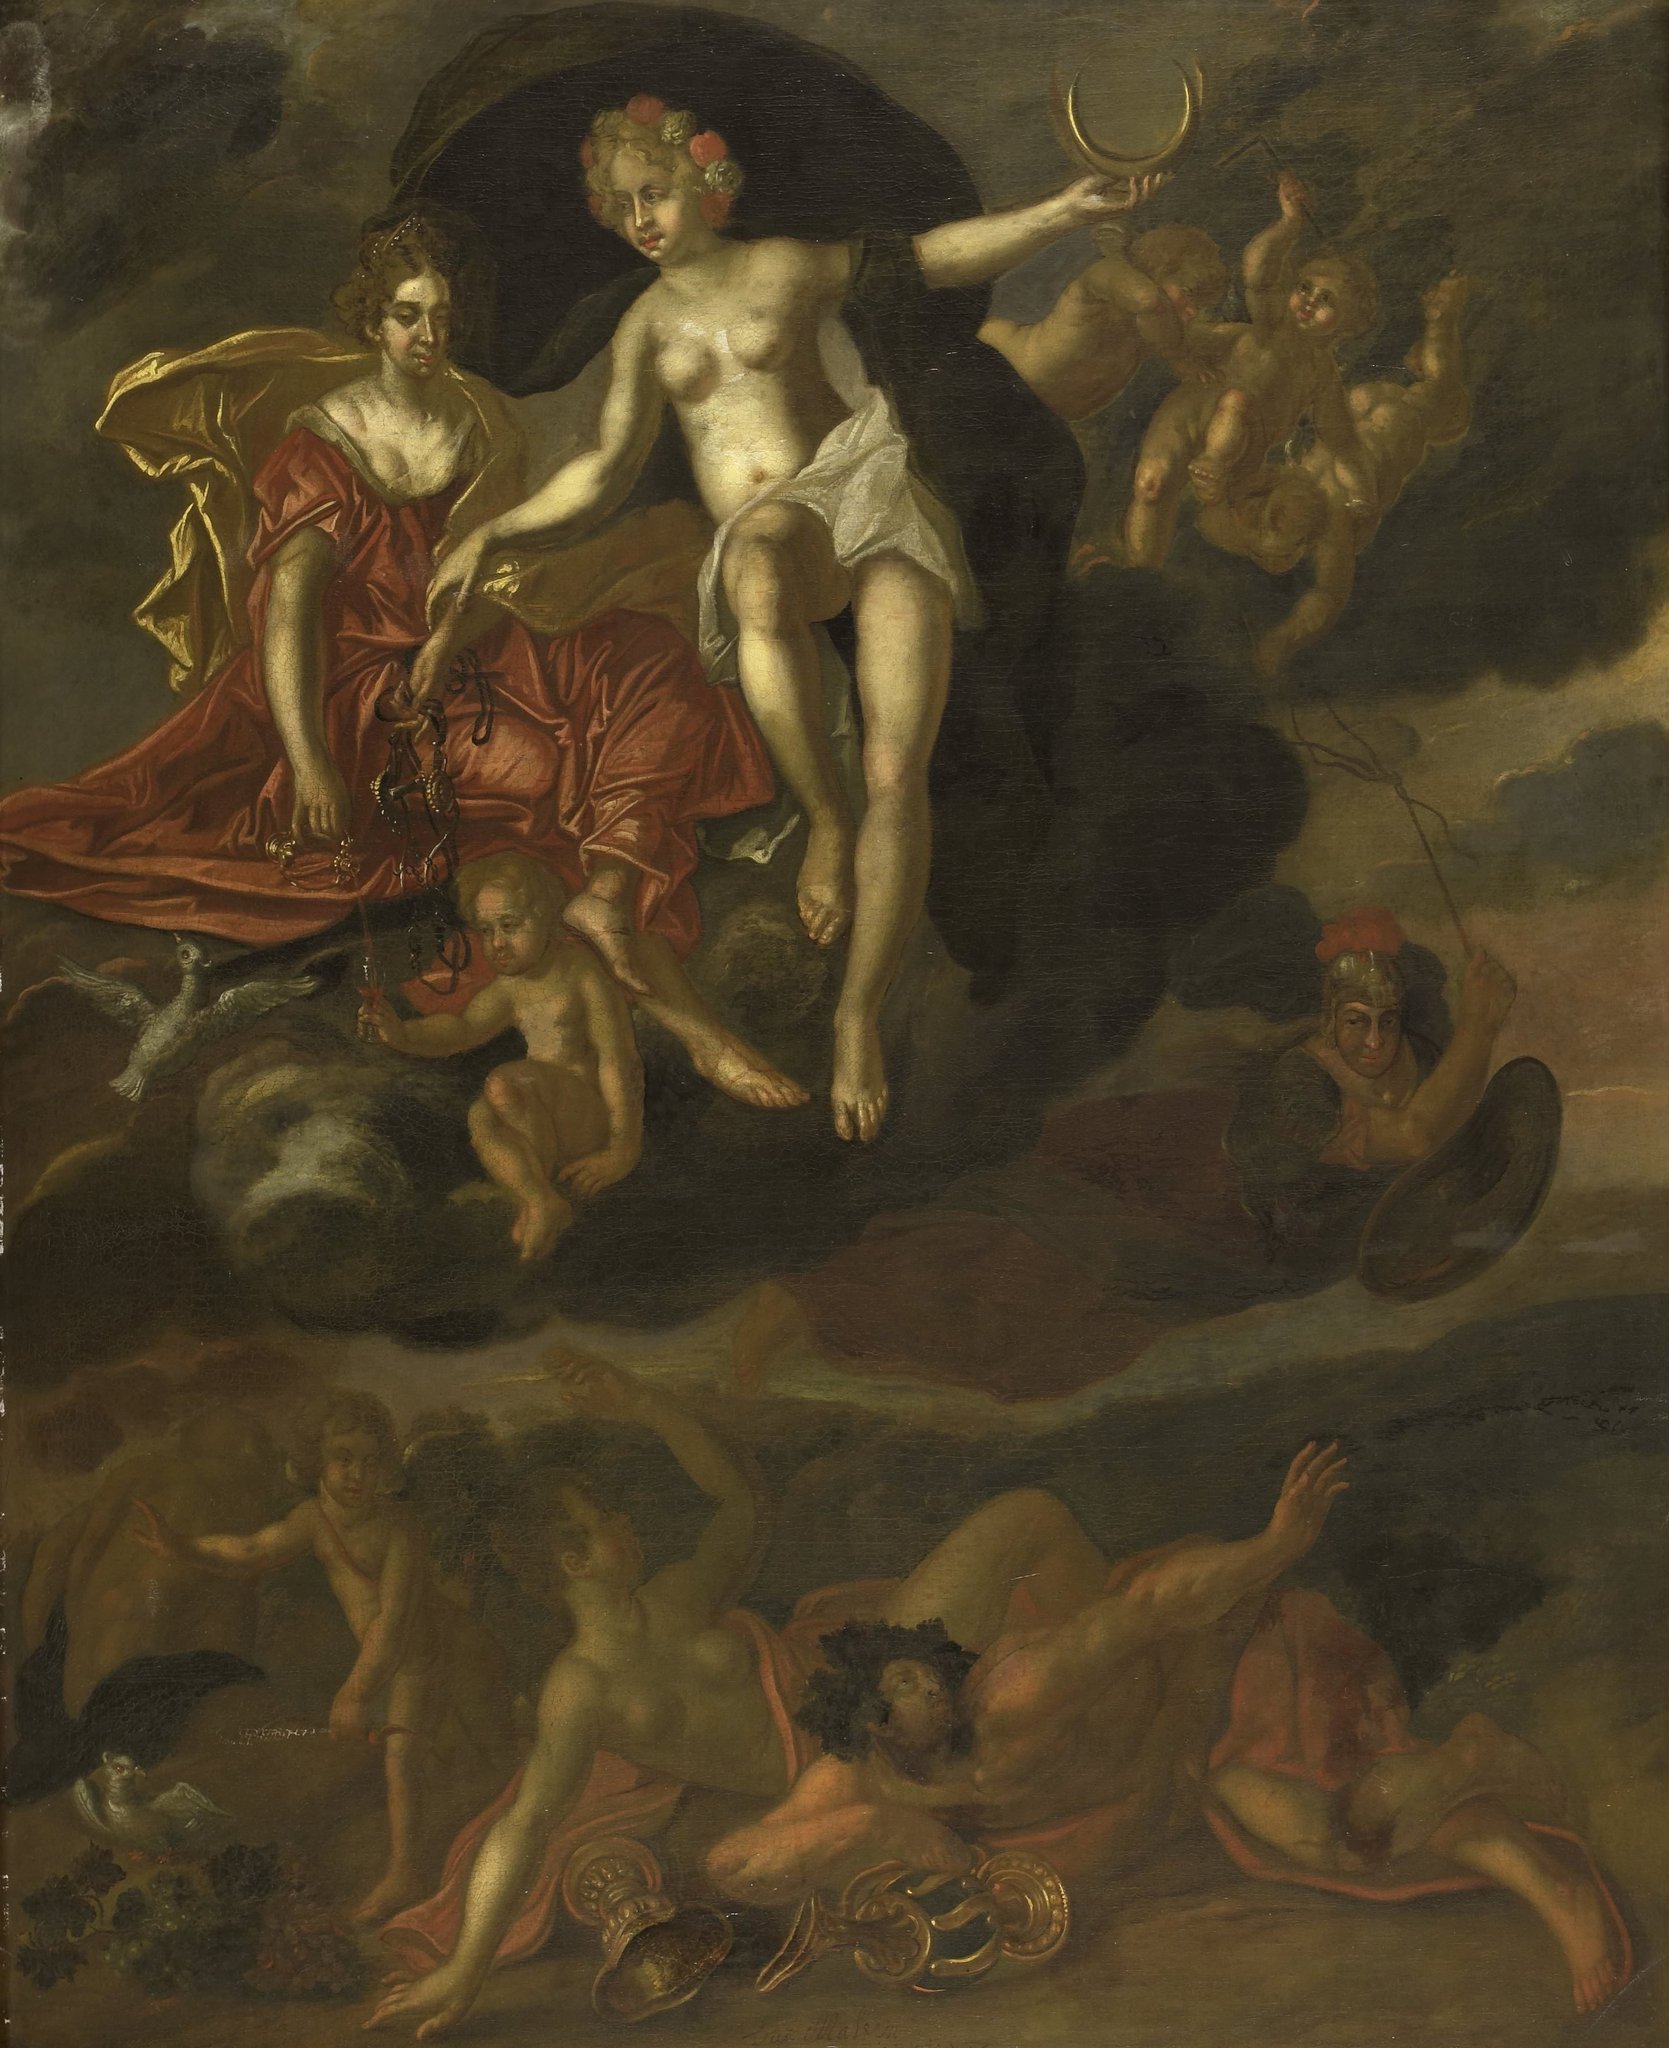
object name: painting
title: Diana and Virtus Punish Venus and Bacchus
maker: t. van malsen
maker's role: painter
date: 1694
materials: canvas, oil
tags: (story of) diana (artemis), (story of) bacchus (dionysus), liber, virtus as roman personification, (story of) venus (aphrodite)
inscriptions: signature and date: ‘Van Malsen inventor 1694’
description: Diana en Virtus bestraffen Venus en Bacchus. De personificatie van Deugdzaamheid (of Temperantia, de Matigheid?) heeft een breidel in de linkerhand en schenkt met de rechterhand uit een kan. Diana houdt een maansikkel in de linkerhand. Venus en Bacchus rollen op de grond tussen omgegooide kannen. Links Cupido met een duif.